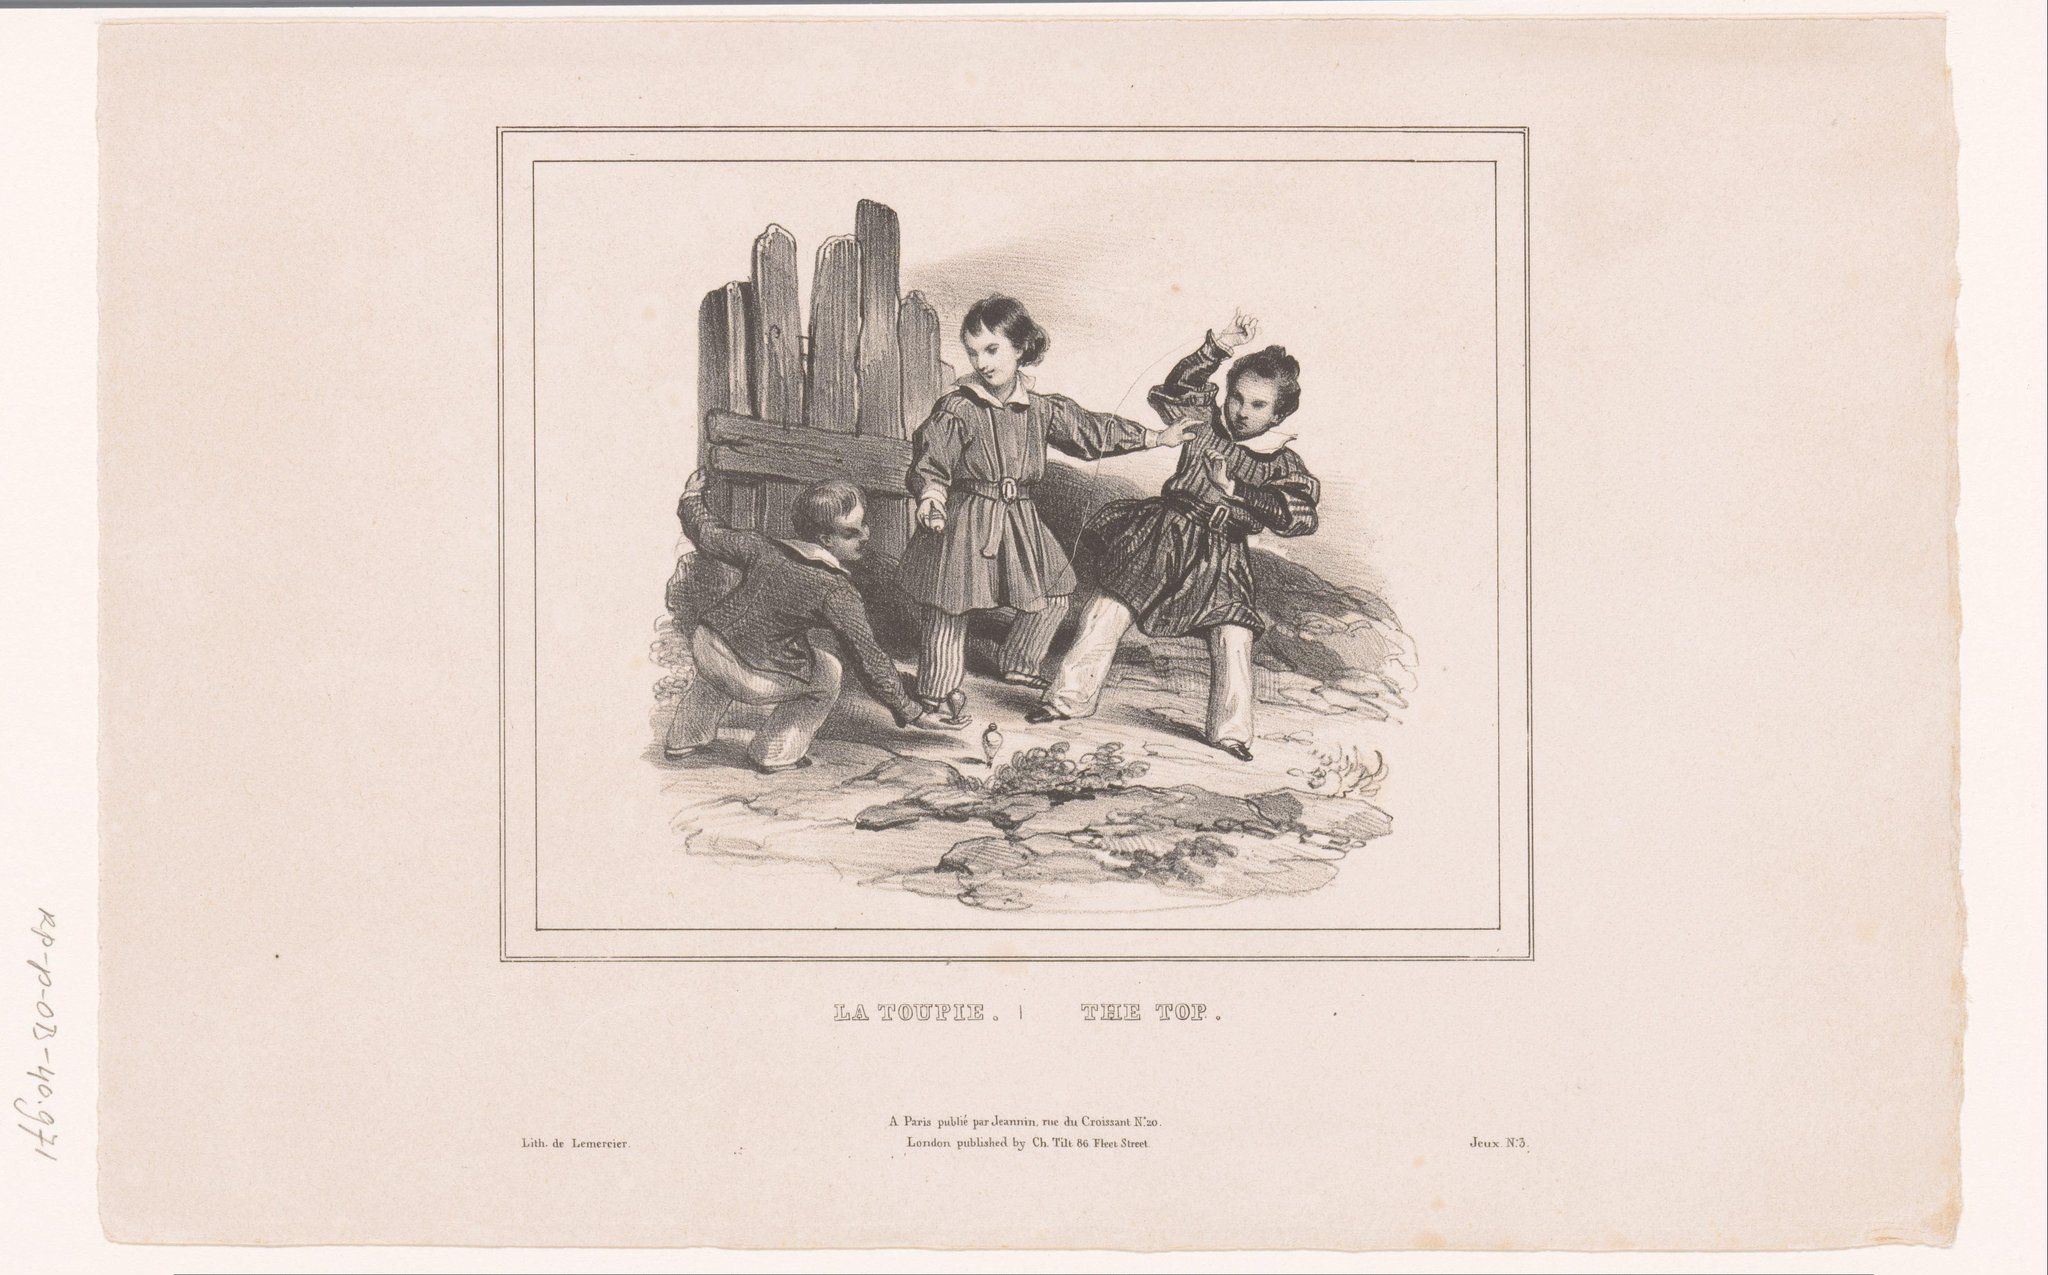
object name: print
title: La toupie / The top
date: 1832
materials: paper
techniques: lithograph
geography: paris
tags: (playing with) revolving toys, boy (child between toddler and youth), (playing with) top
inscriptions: check stamp: Lugt 1397c, collector's mark: Lugt 2166